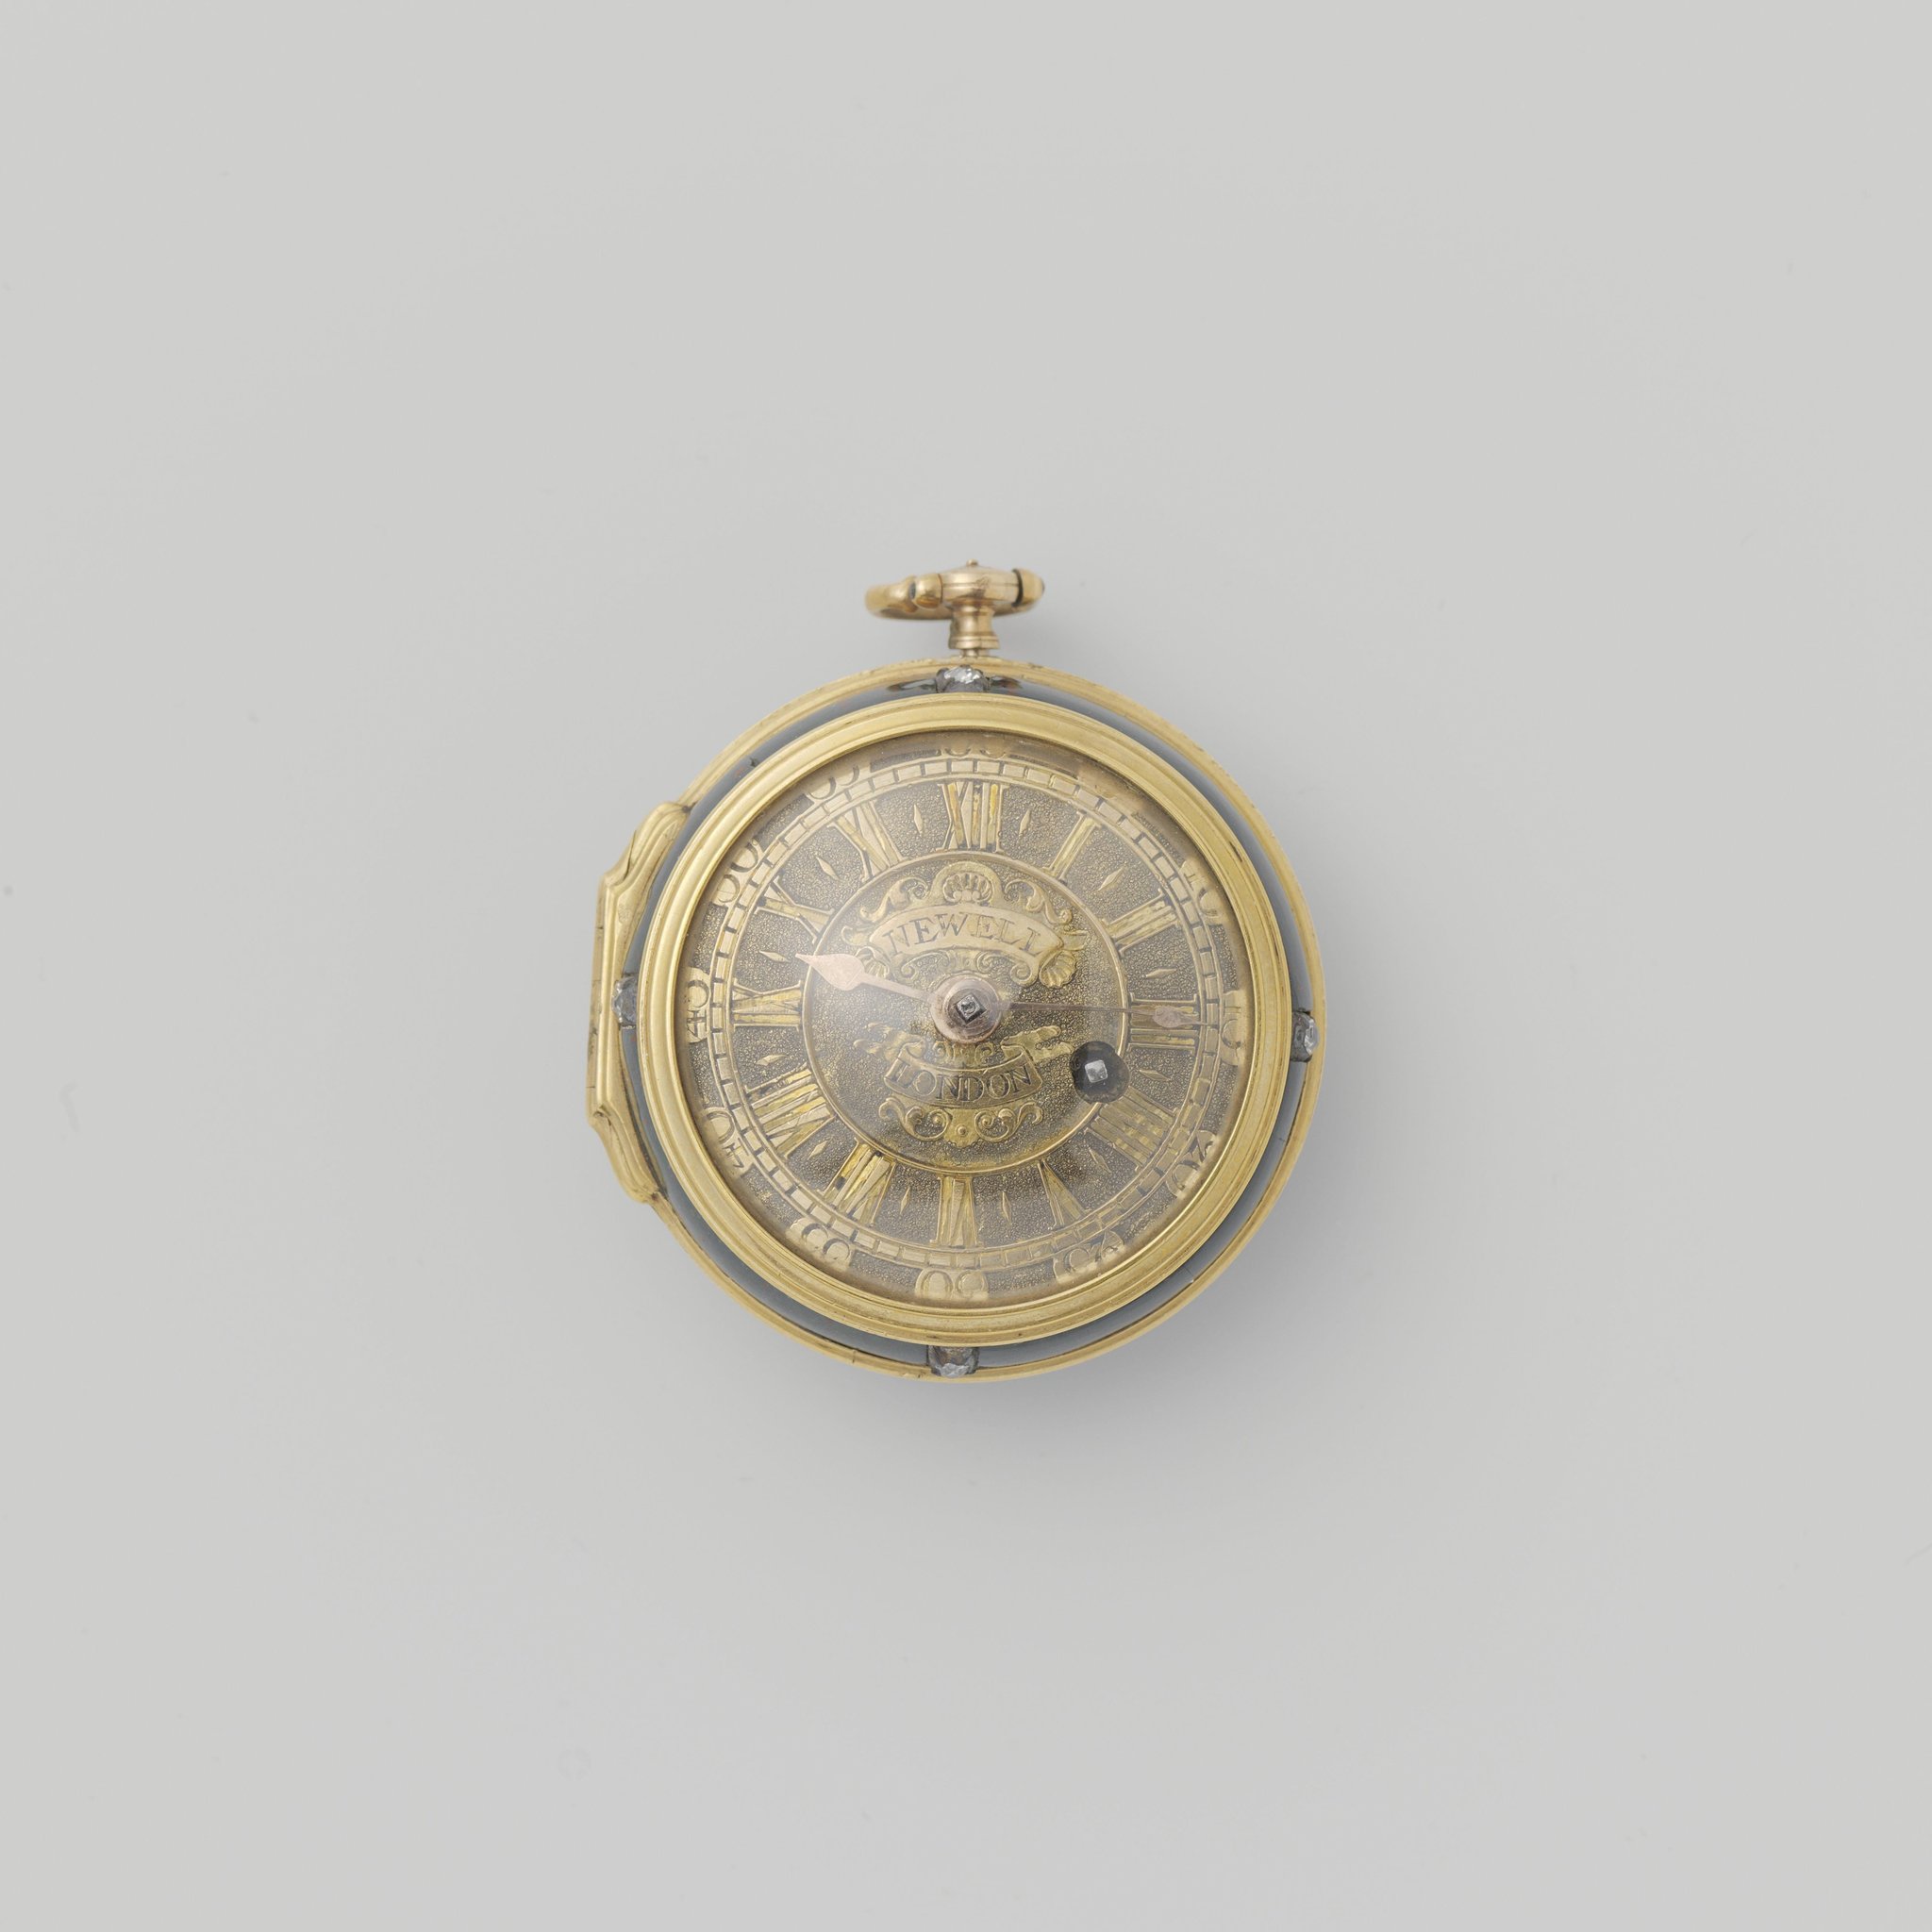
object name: wrist watch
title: Watch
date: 1720-1770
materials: diamond, gold, jasper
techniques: metalworking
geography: london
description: Gouden horloge met geciseleerde wijzerplaat. De achterbodem en rand van de voorbodem zijn van bloedjaspis. Met diamanten op de drukknoppen.